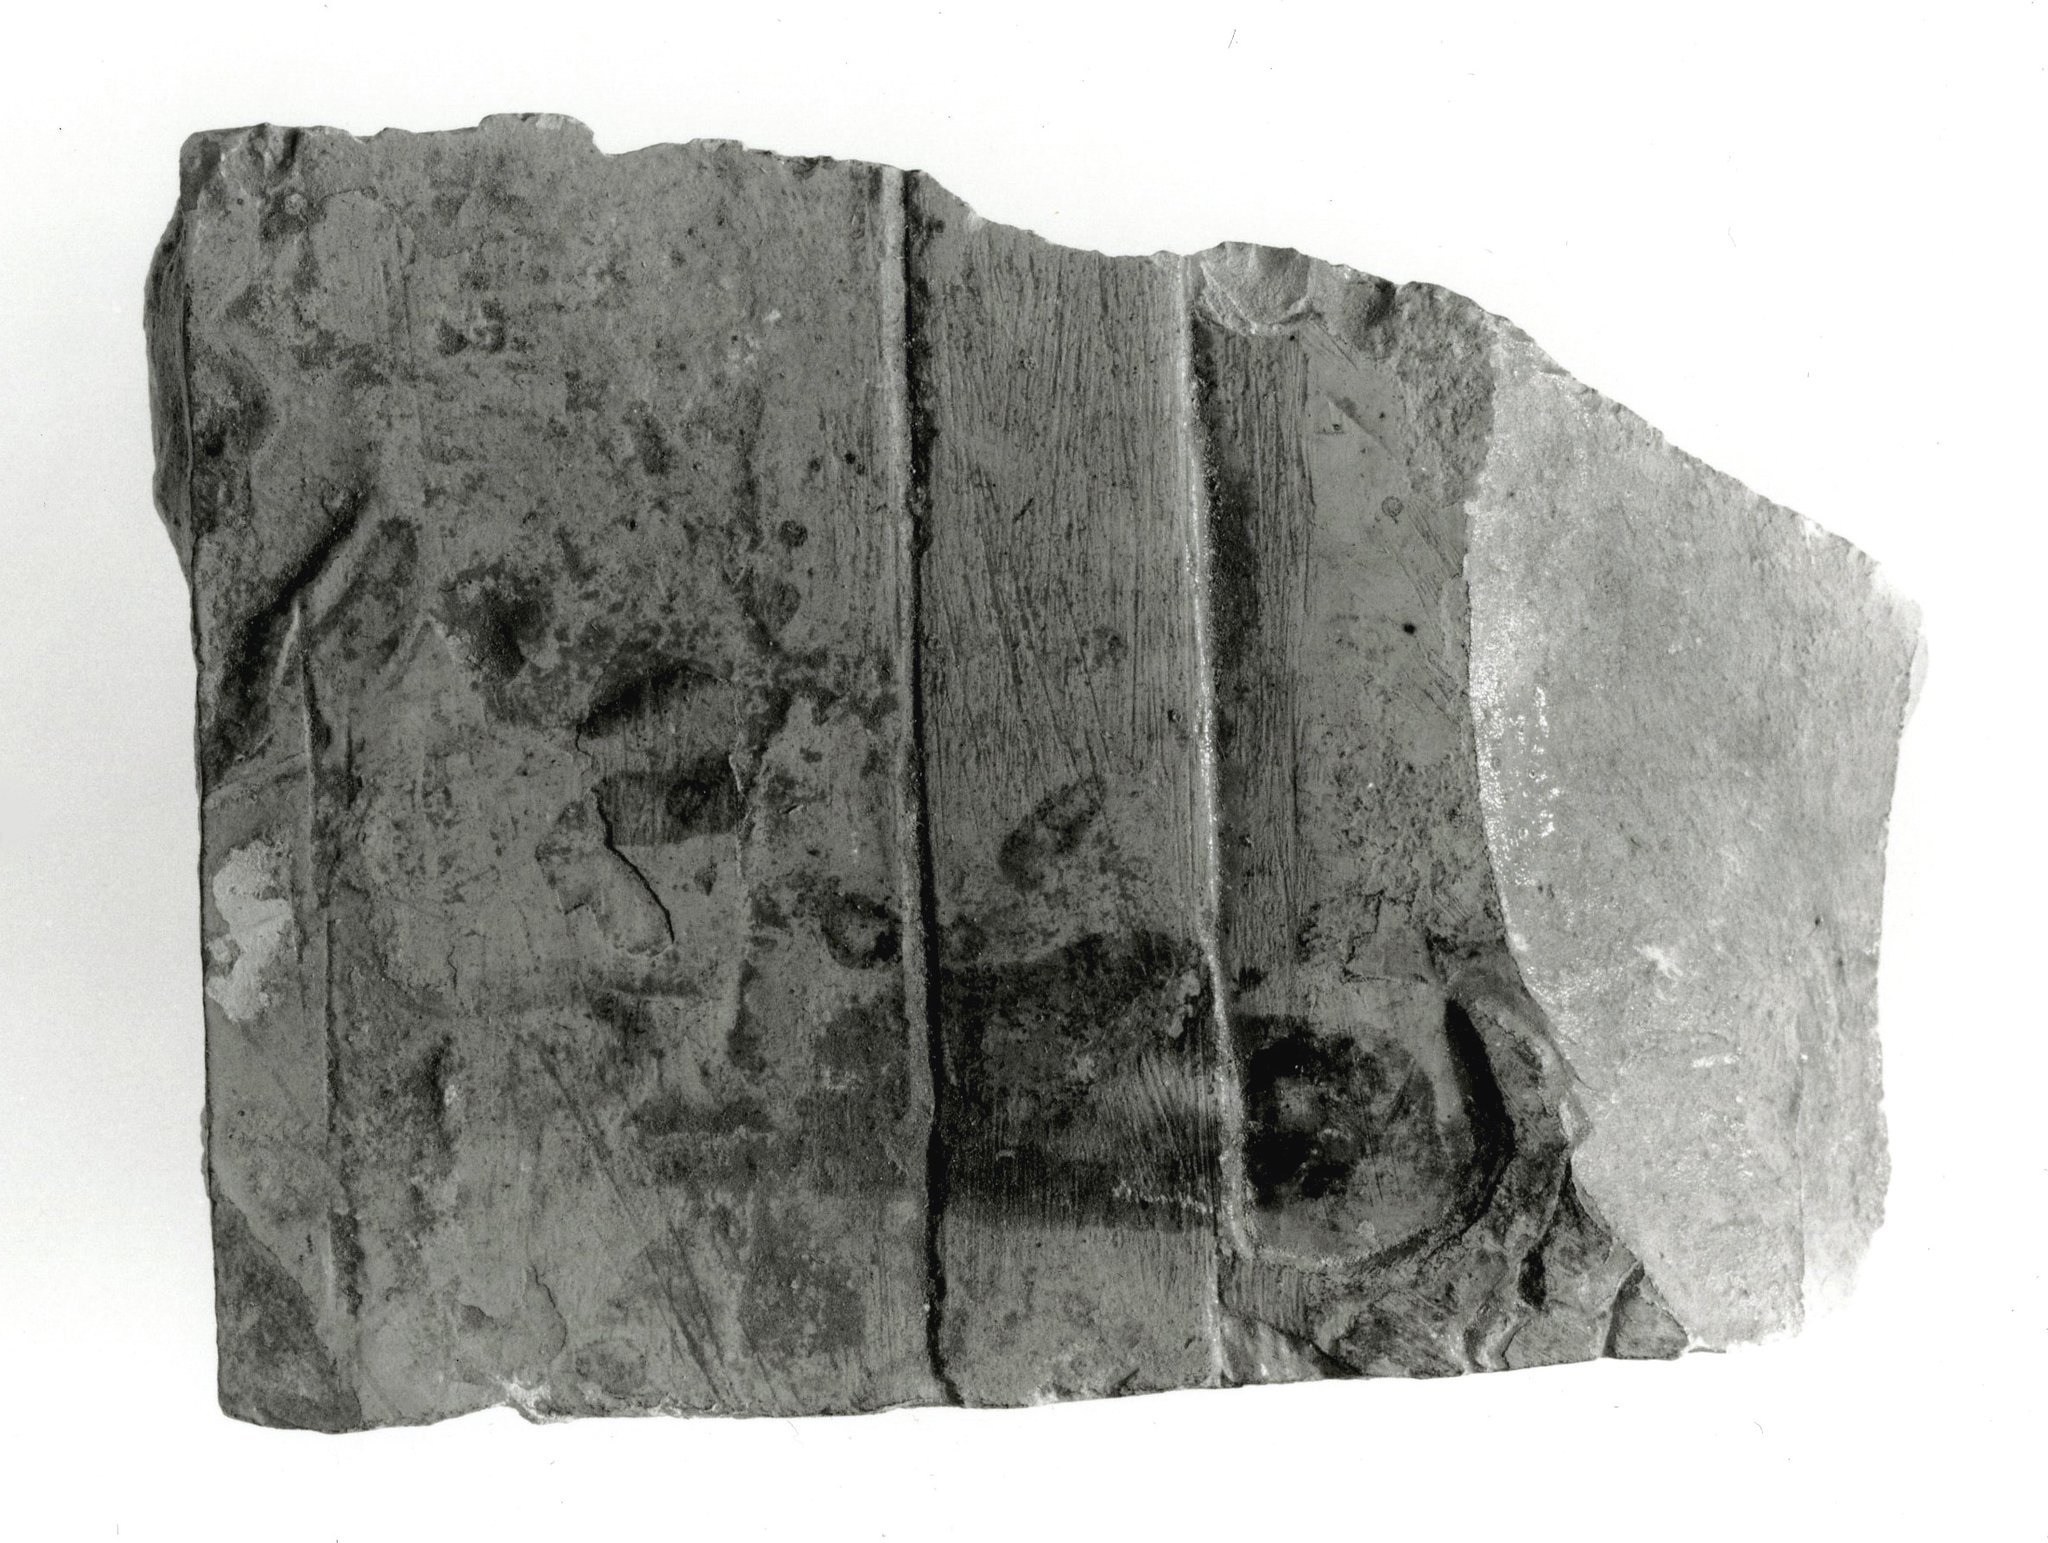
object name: relief, tomb of nespekashuty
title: Raised relief fragment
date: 664-610 BCE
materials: limestone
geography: egypt